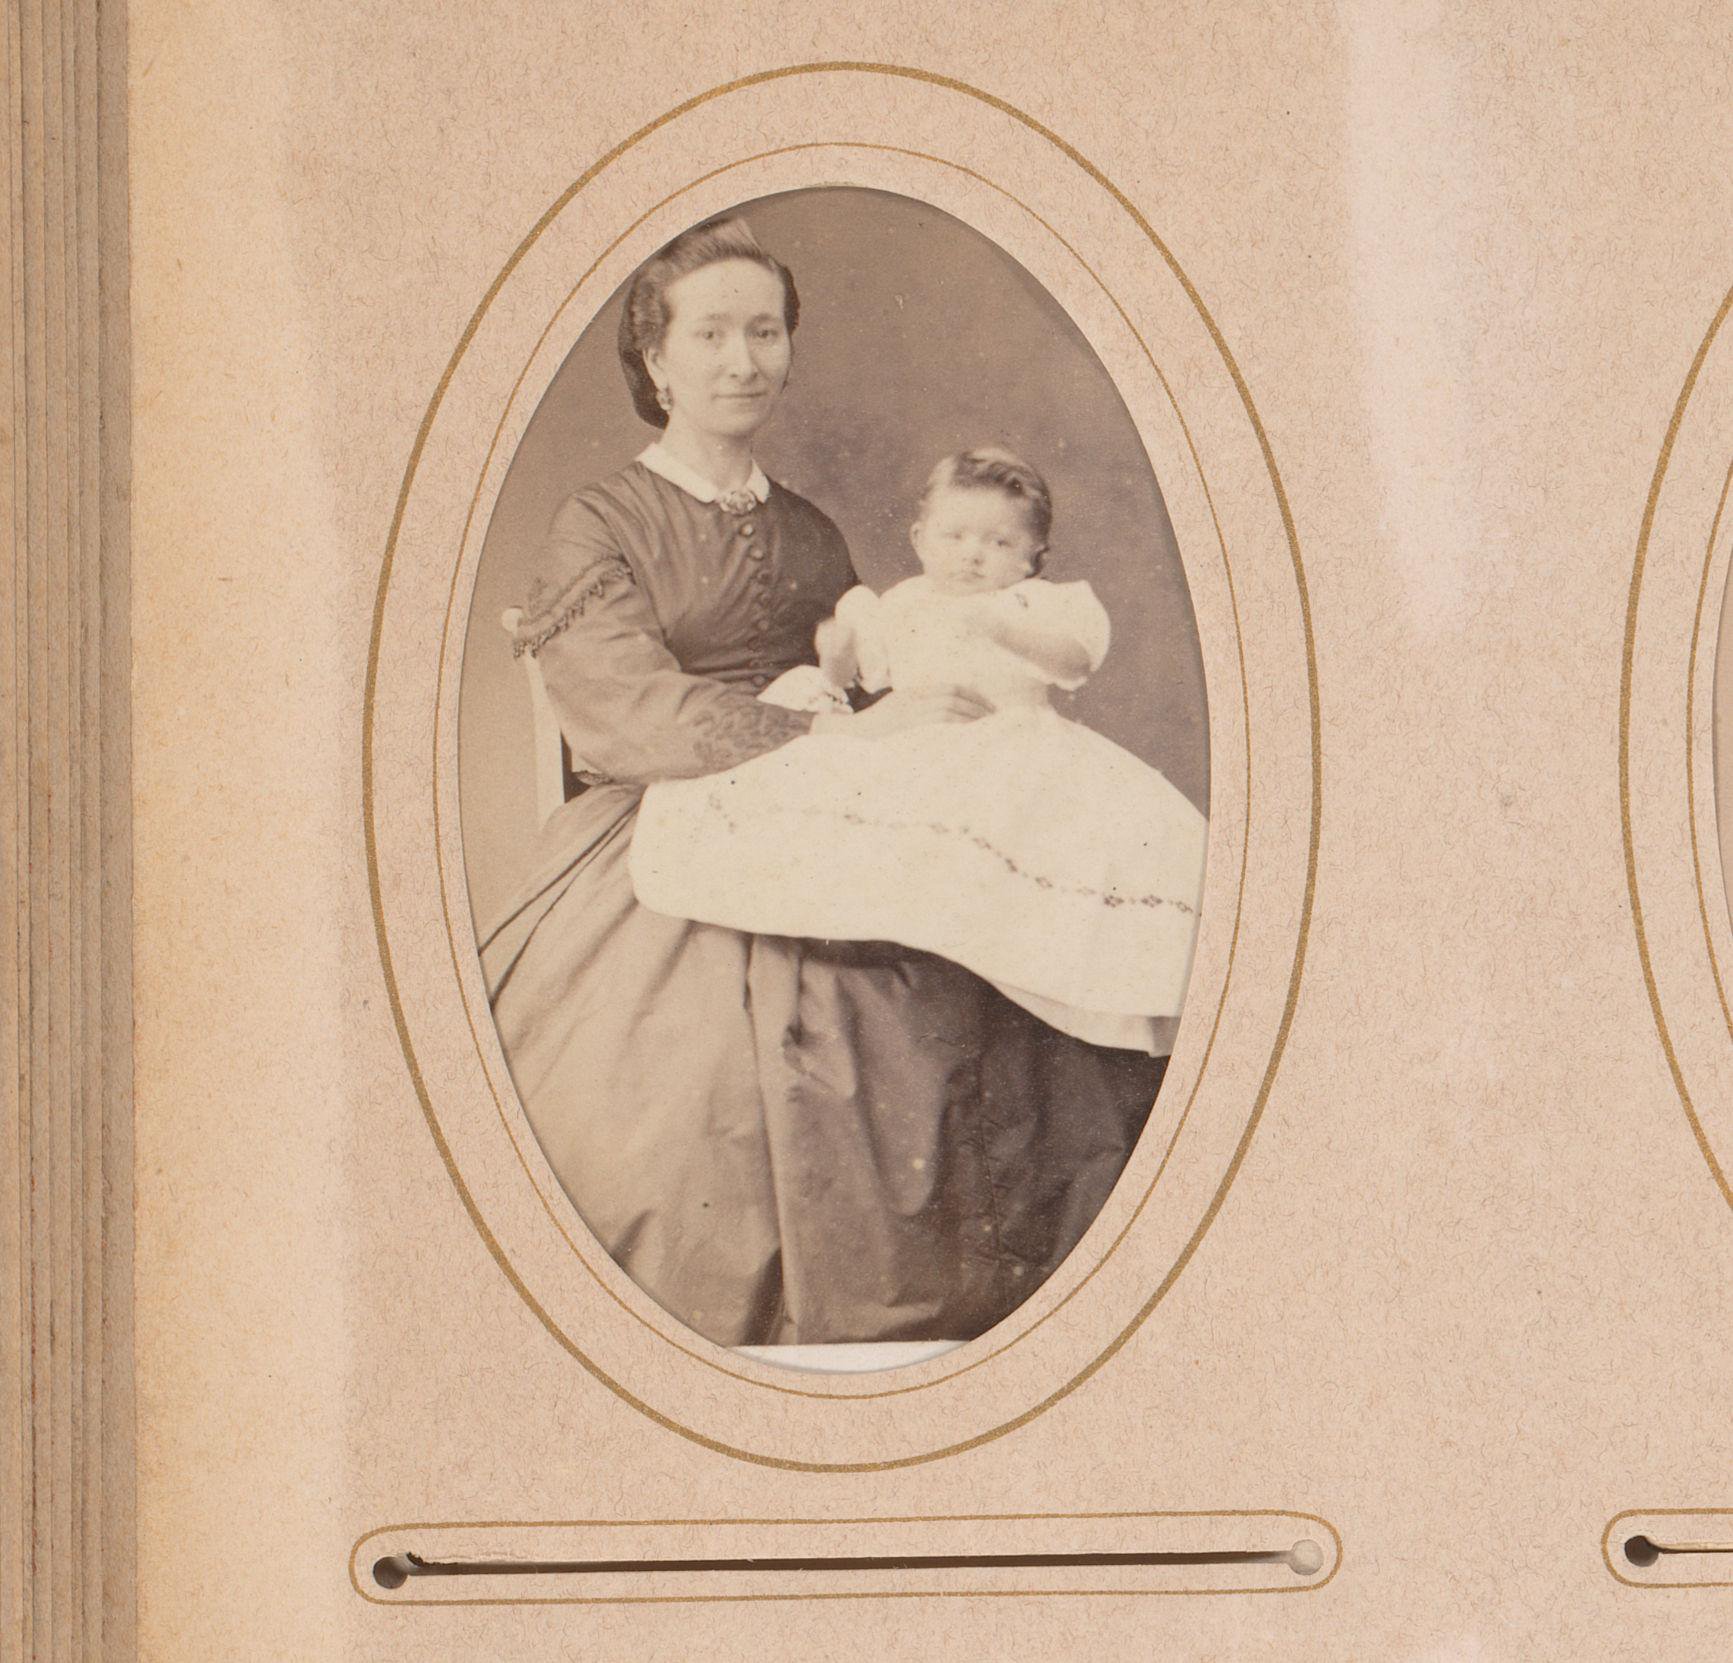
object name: album leaf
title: Portret van een moeder met kind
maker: k. kuipers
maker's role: fotograaf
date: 1860-1890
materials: cardboard, photographic support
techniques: albumen print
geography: workum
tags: mother and child(ren), woman and child(ren) (family group)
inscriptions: inscription: ‘Photographie/ K. Kuipers/ te/ Workum’